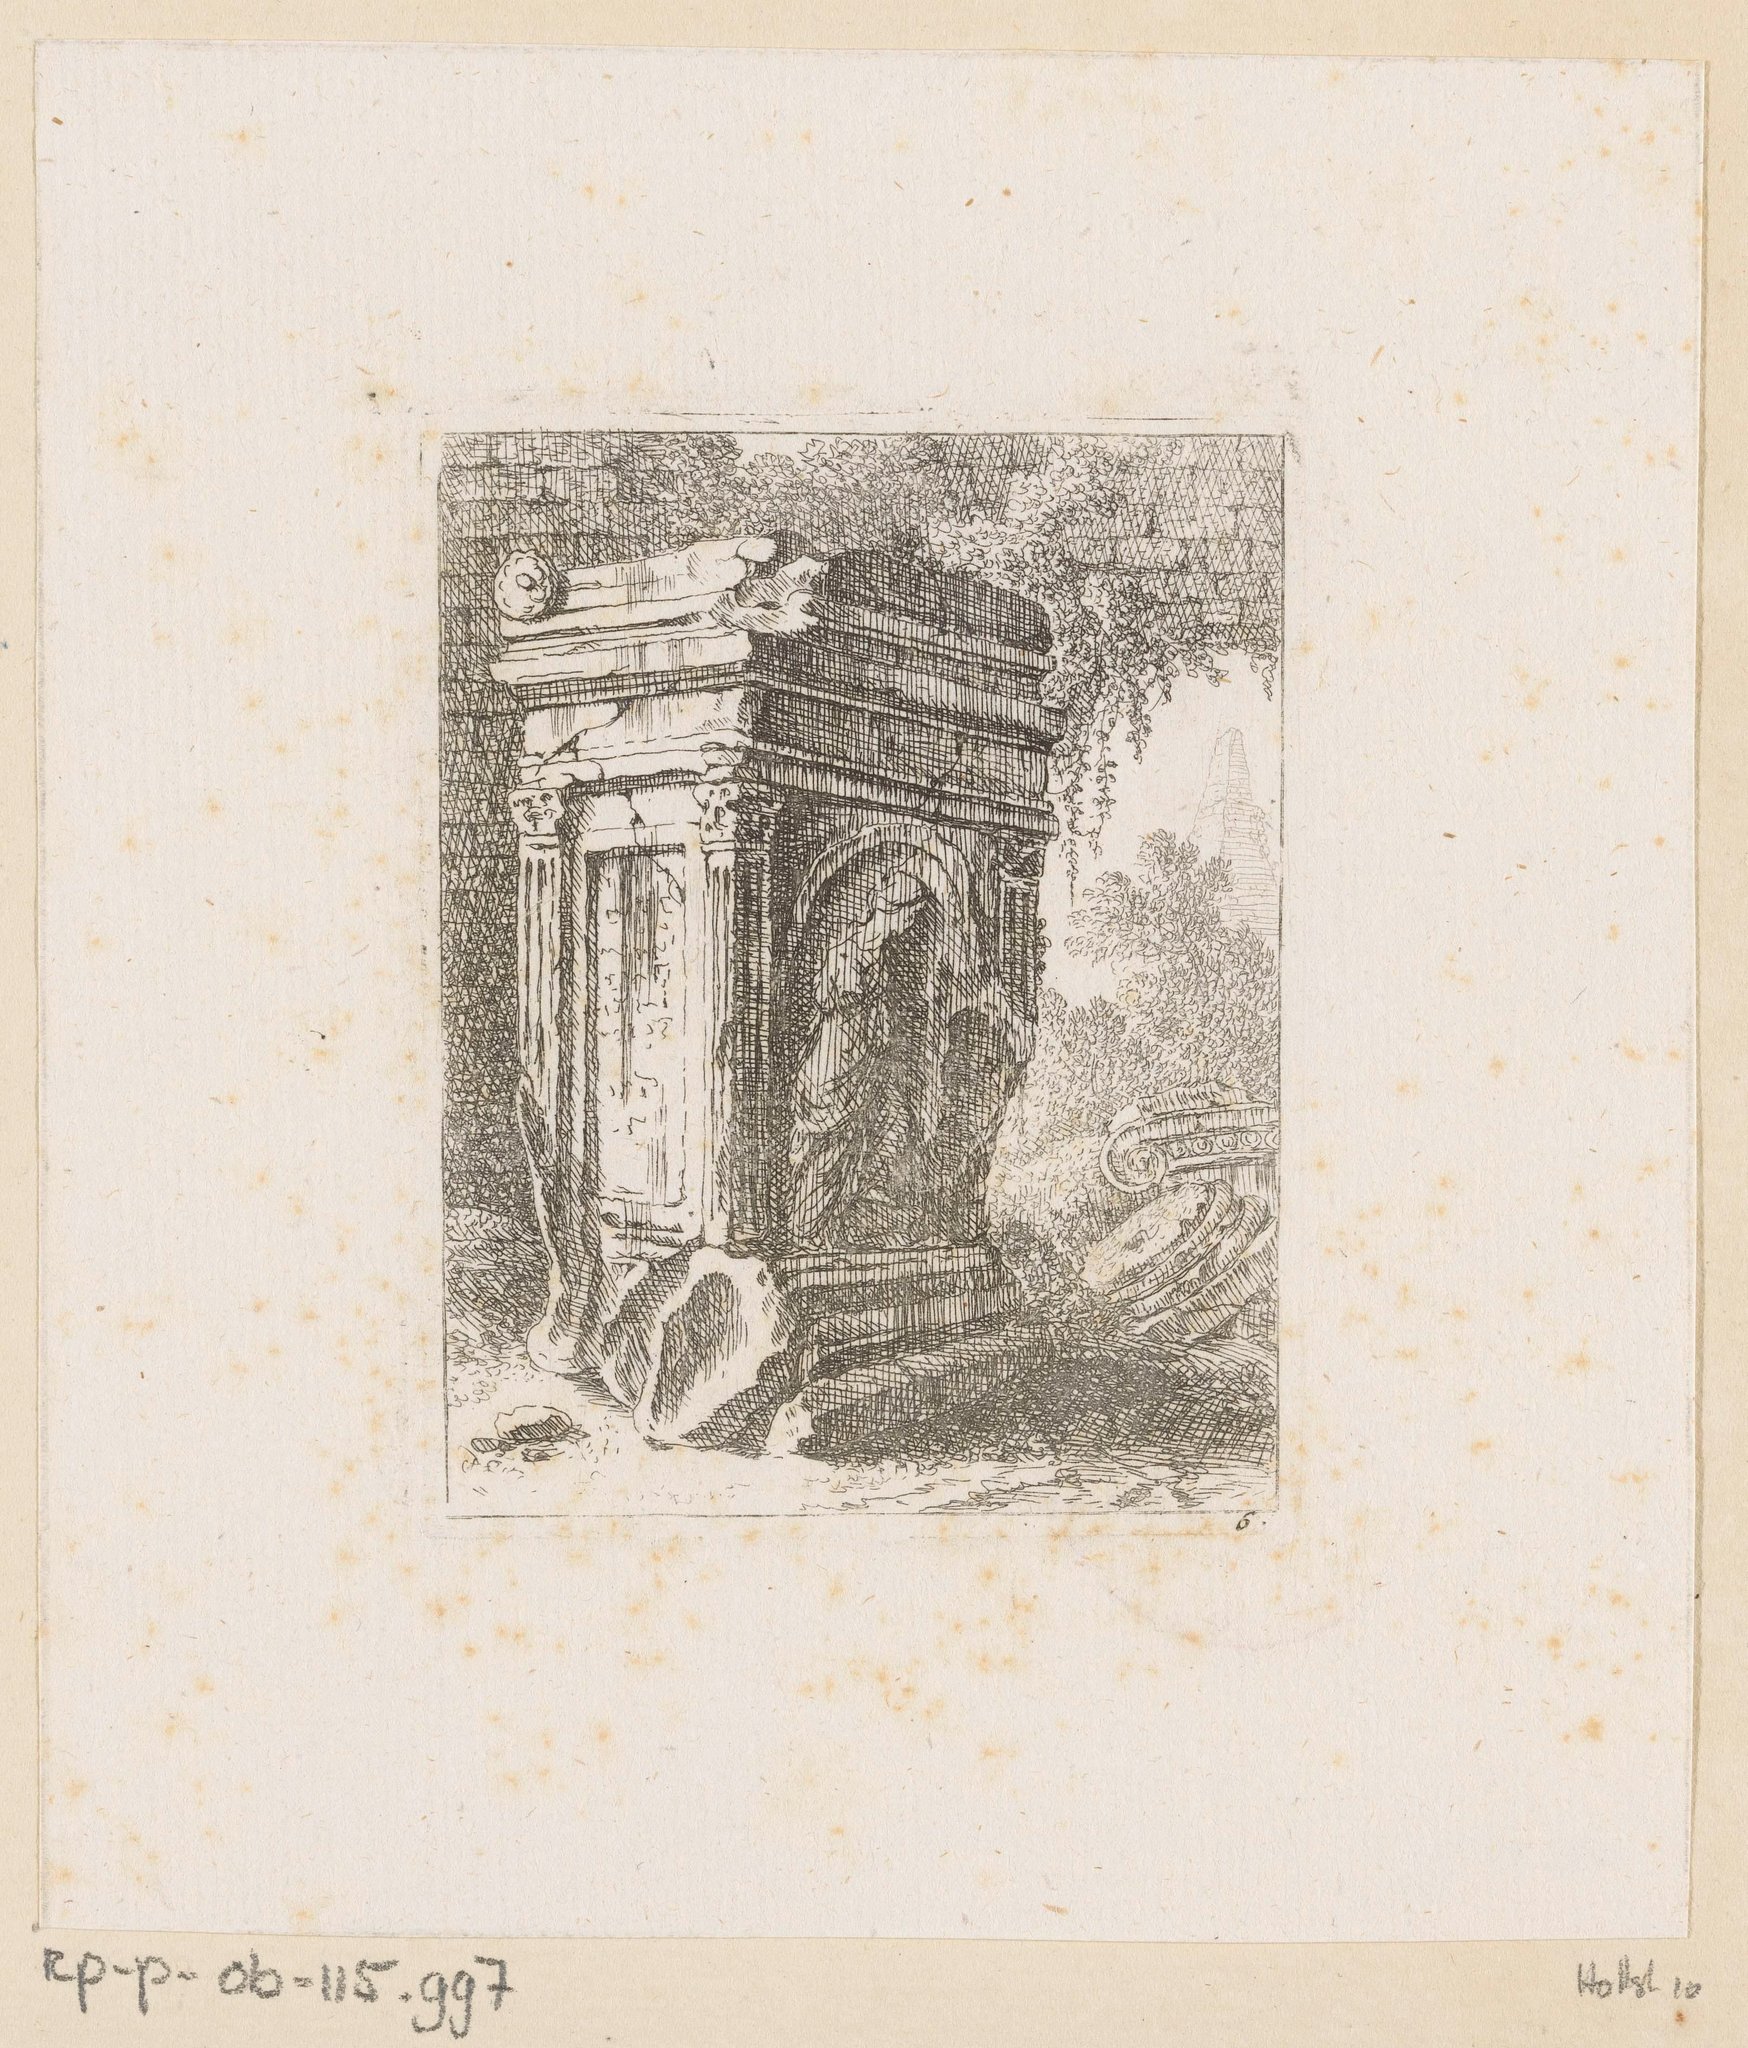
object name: print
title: Romeinse ruïnes en monumenten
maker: johann franz ermels (der ältere)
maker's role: draughtsman, print maker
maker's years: 1641-1693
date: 1651-1693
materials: paper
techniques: etching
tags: landscape with ruins, monument, statue, surface decorations ~ architecture, rome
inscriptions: collector's mark: Lugt 240